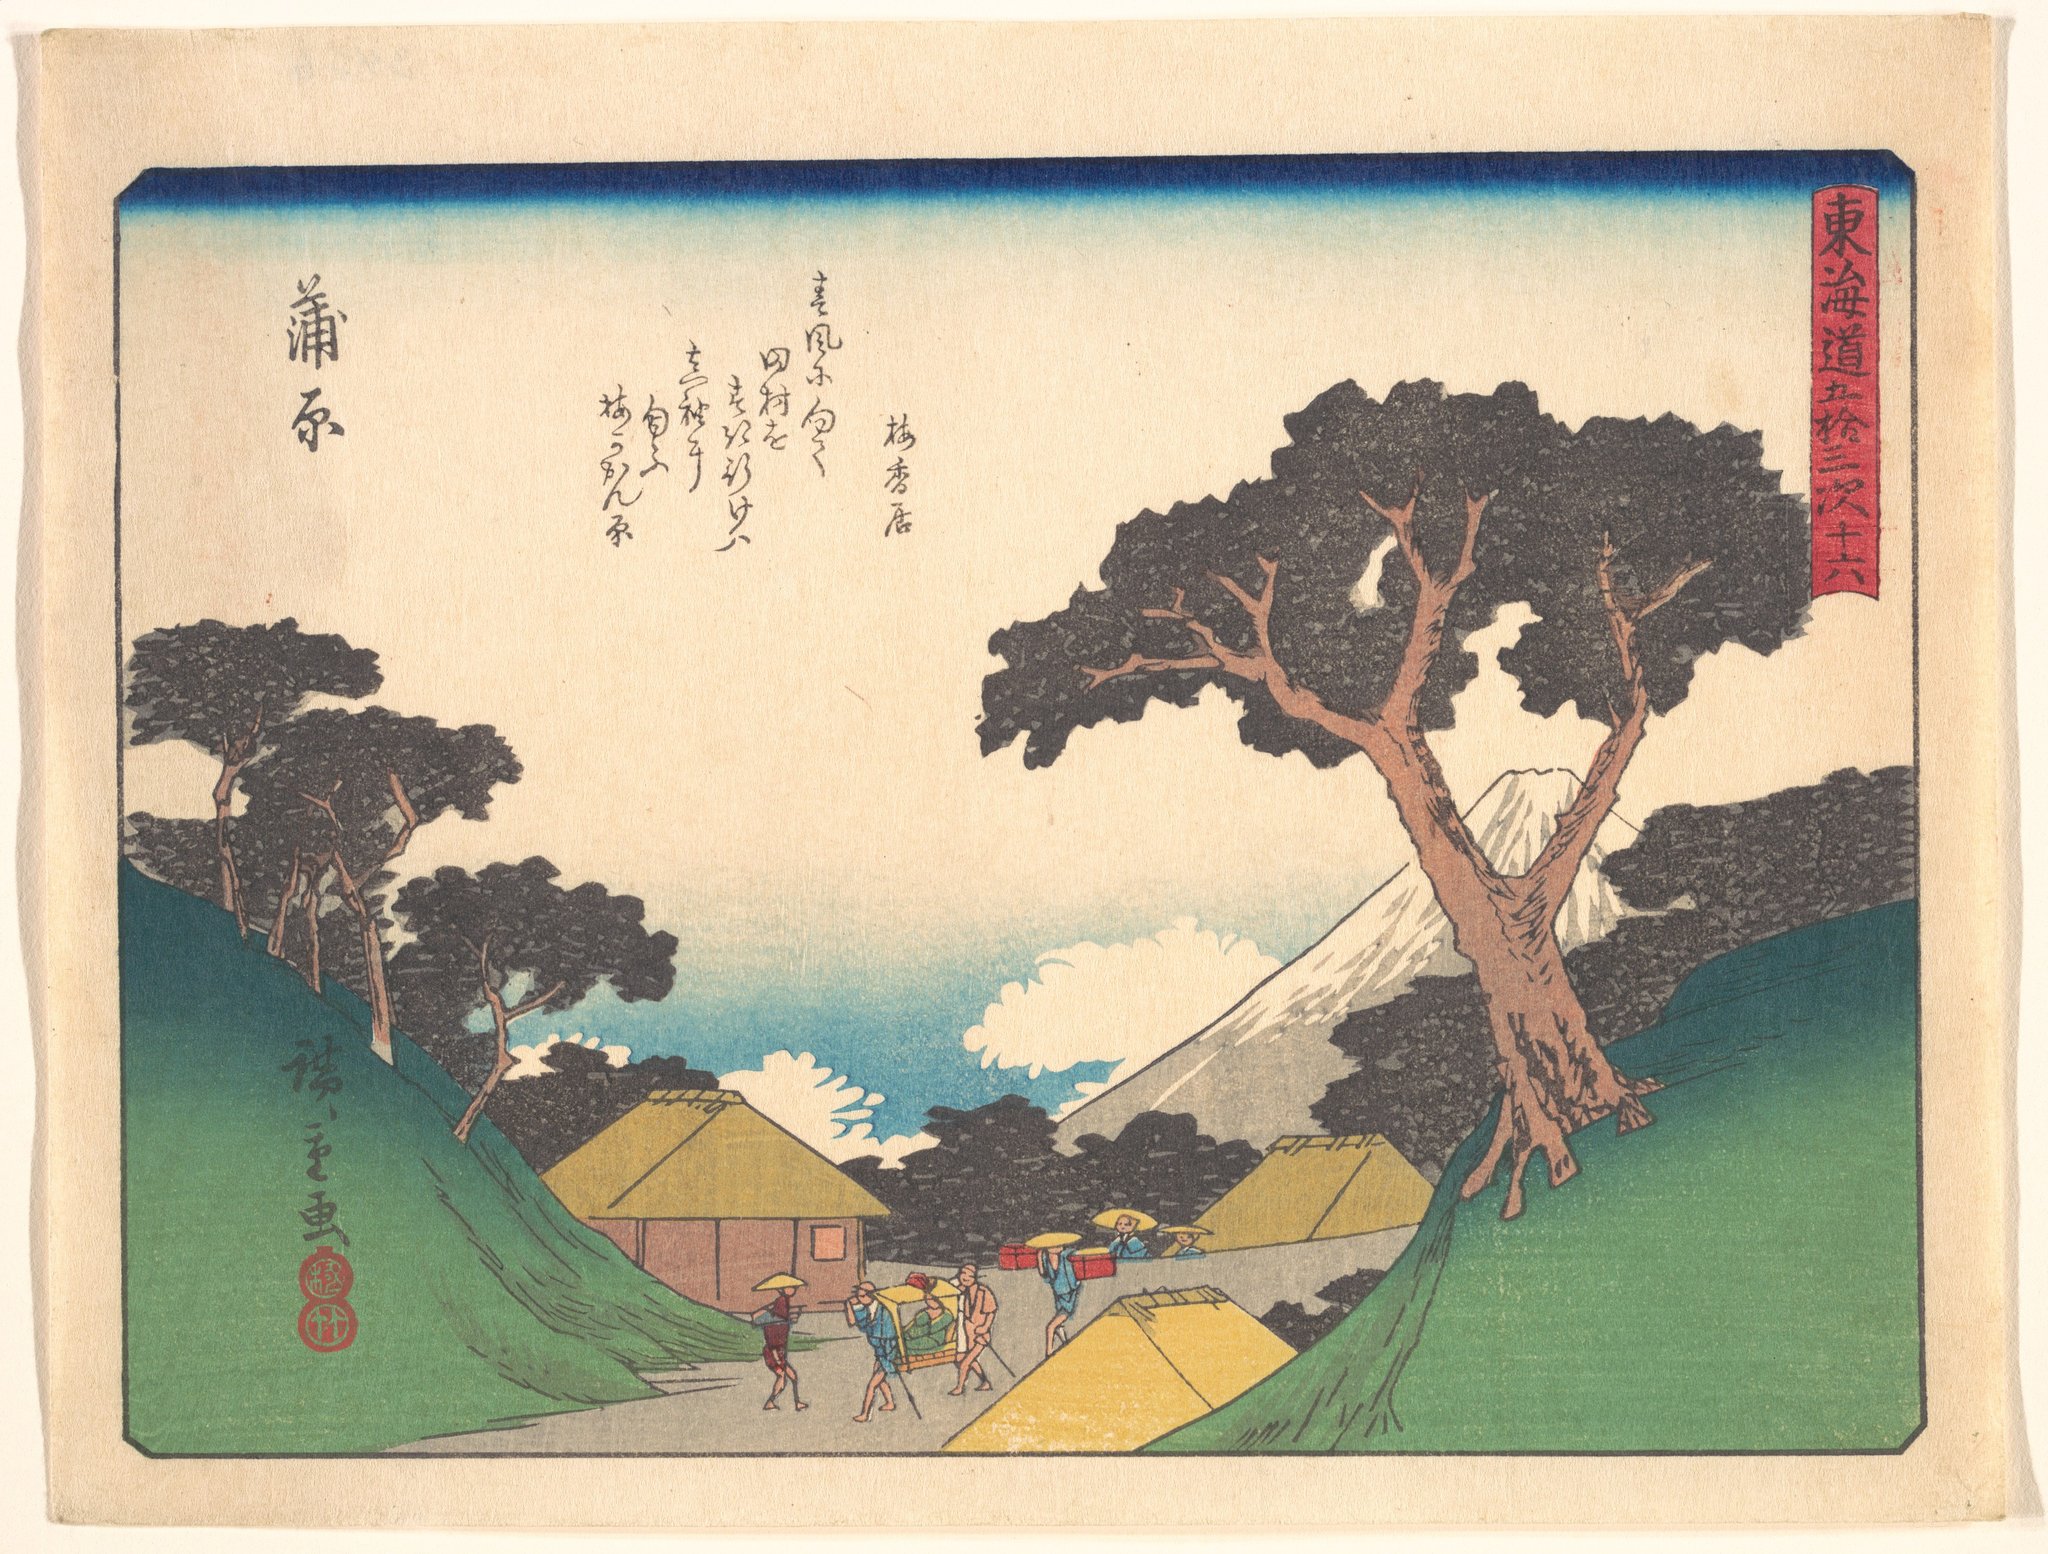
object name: print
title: 東海道五十三次 蒲原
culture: japanese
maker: utagawa hiroshige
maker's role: artist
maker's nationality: japanese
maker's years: 1797-1858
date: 1901-1933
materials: ink, paper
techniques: woodblock print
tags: mountains,landscapes,trees